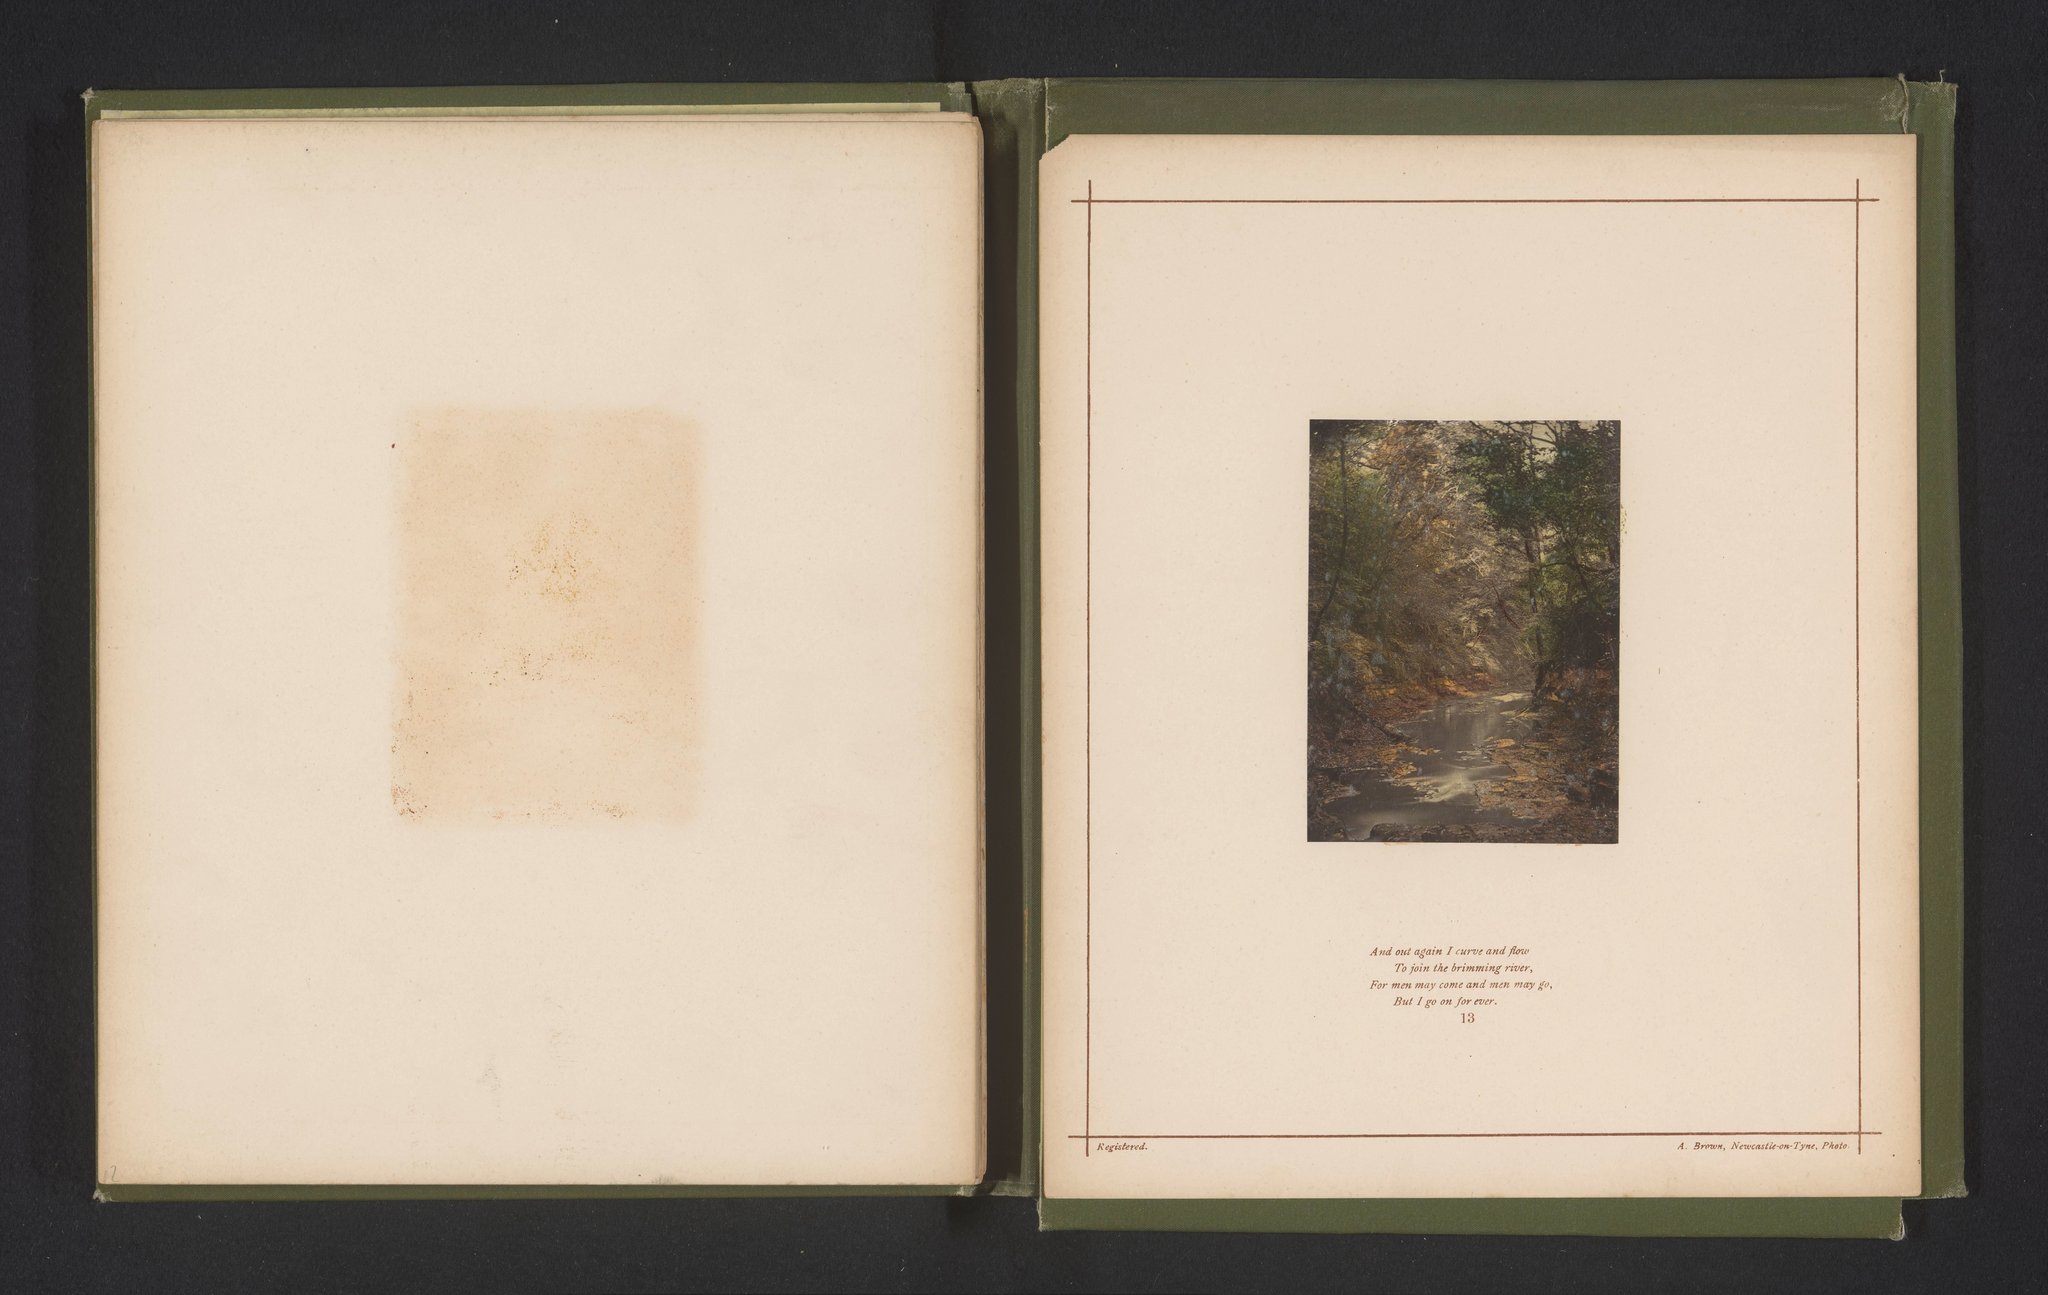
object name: photograph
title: Gezicht op de beek Skelton Beck nabij Saltburn-by-the-Sea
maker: arthur brown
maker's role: fotograaf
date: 1874-1879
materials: paper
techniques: carbon print, hand coloring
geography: north yorkshire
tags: brook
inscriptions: inscription: ‘And out again I curve (...) But I go on for ever.’, number: ‘13’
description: Deze foto maakt deel uit van een omslag met dertien foto's.